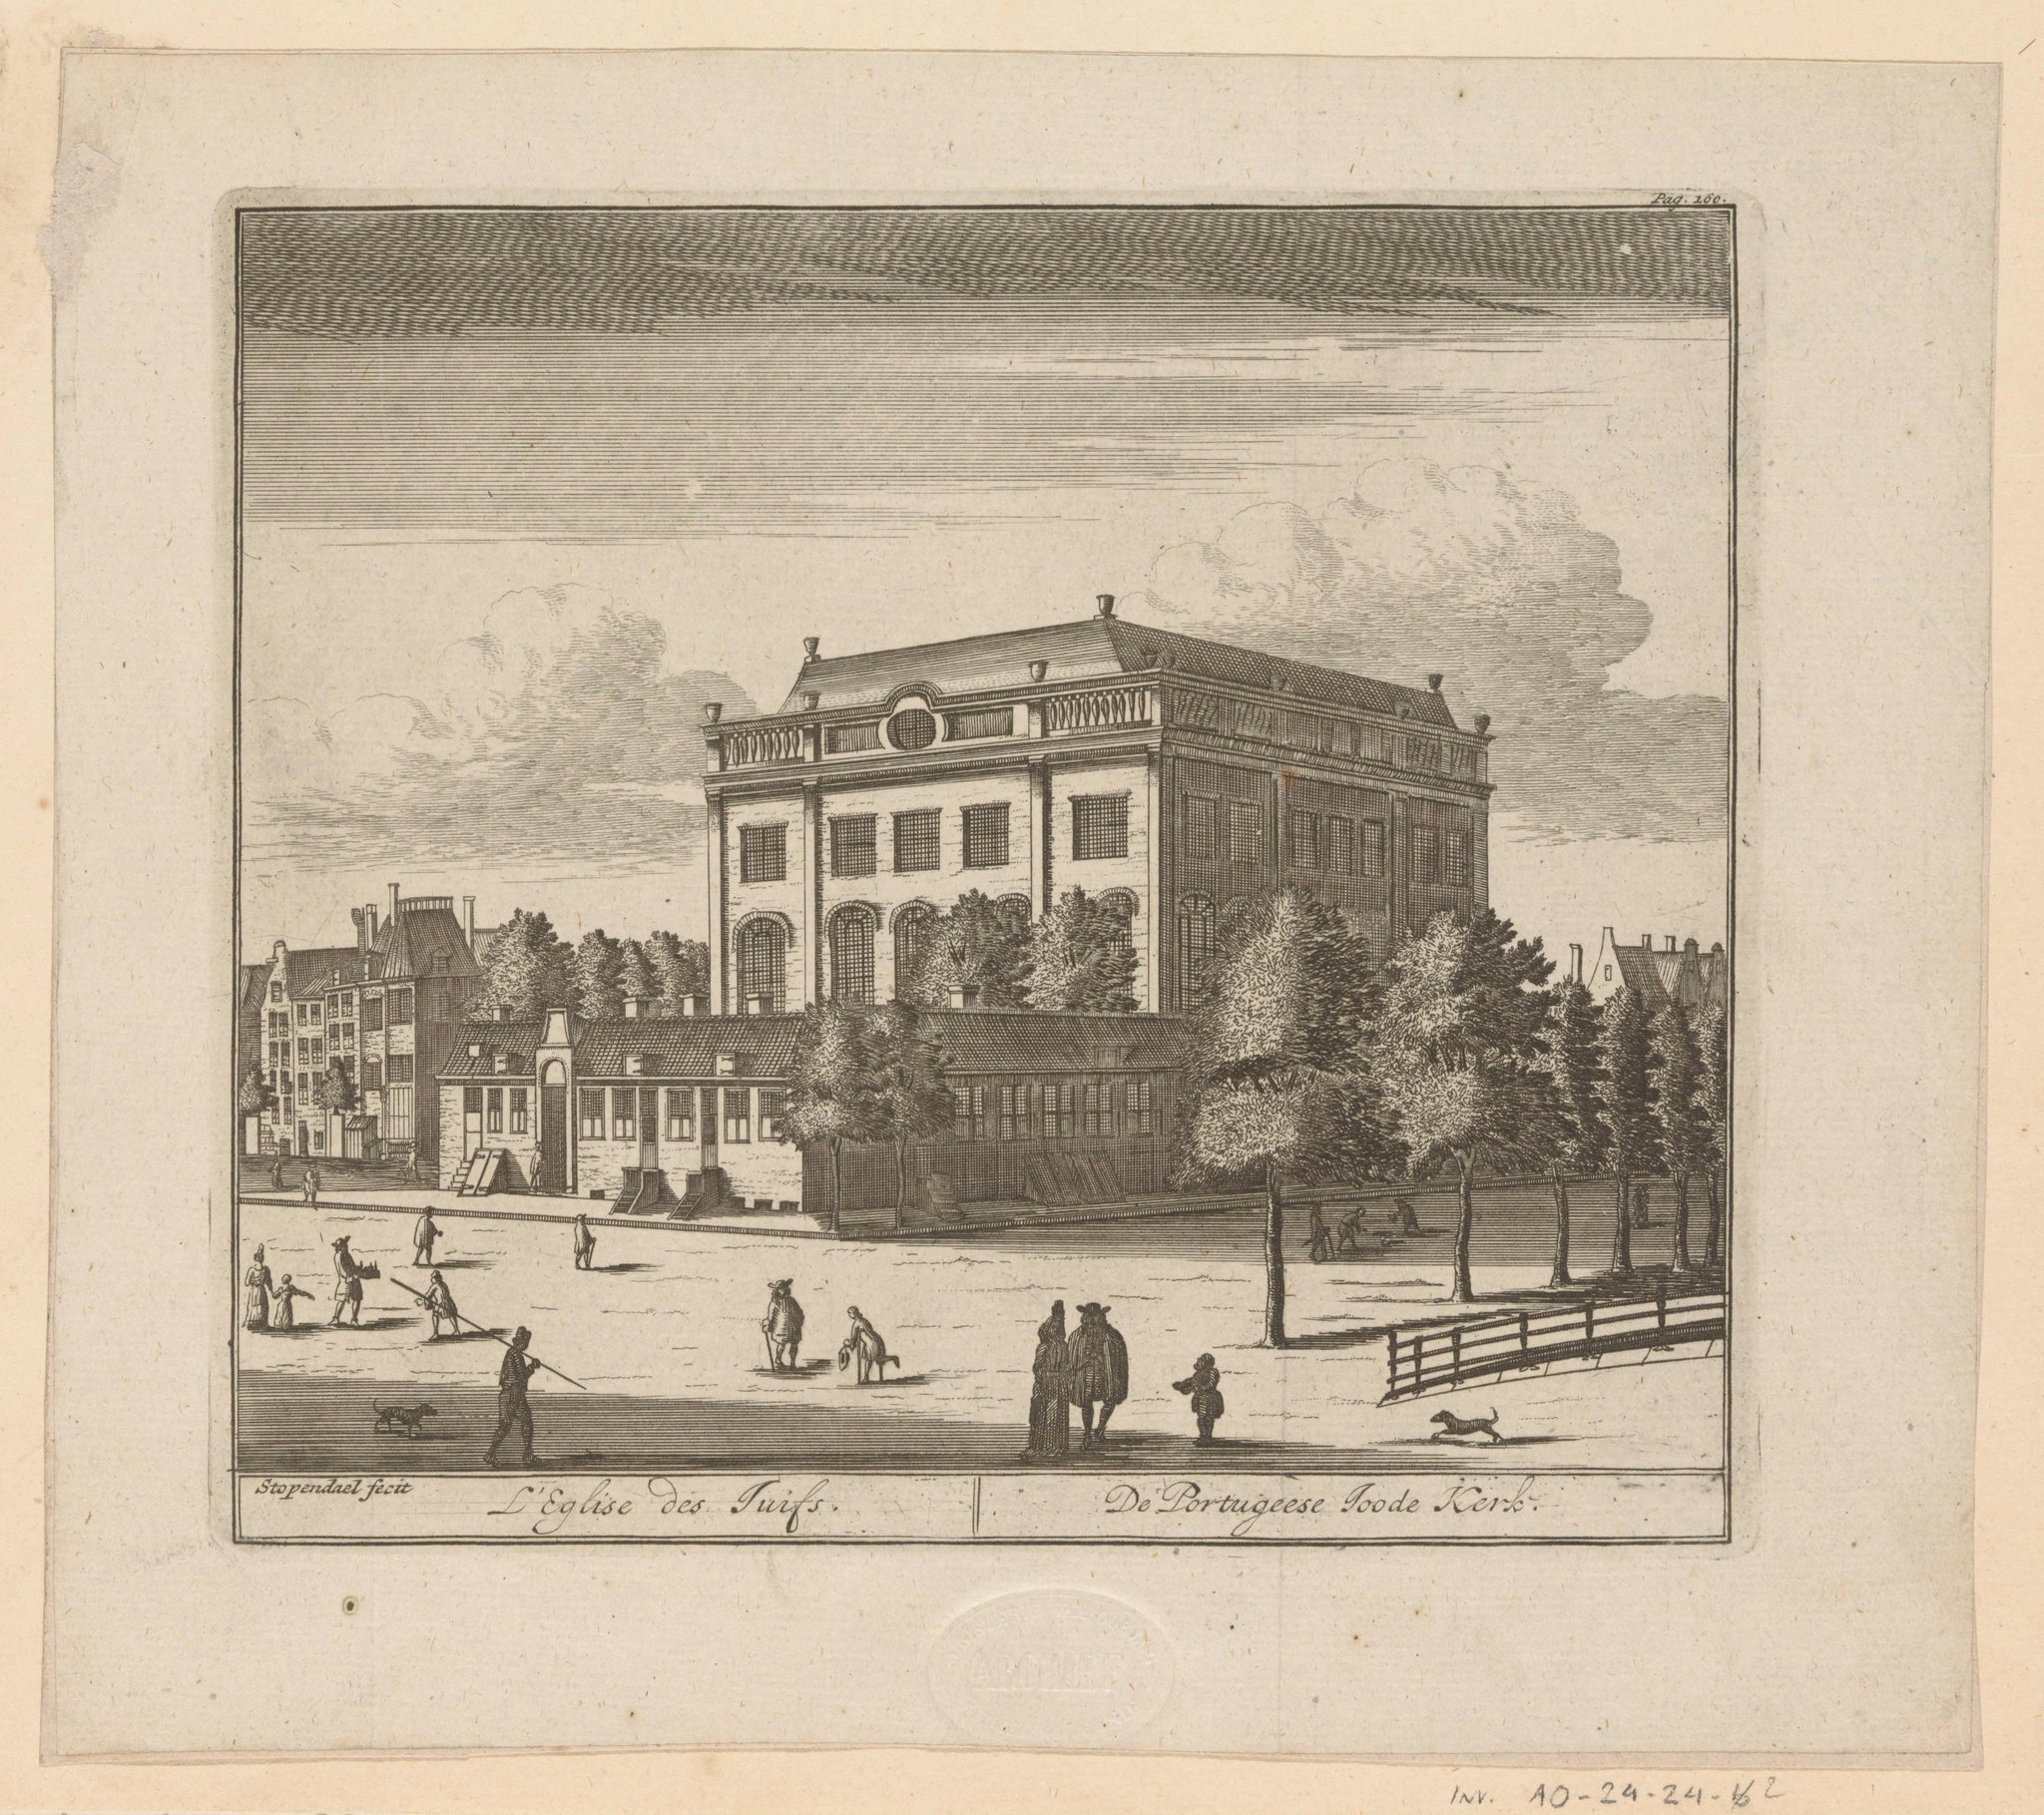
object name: book illustration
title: L'Eglise des Juifs / De Portugeese Joode Kerk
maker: daniël stopendaal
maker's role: print maker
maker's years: 1672-1726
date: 1685-1726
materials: paper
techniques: engraving, etching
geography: amsterdam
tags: 'sephardim' ~ jewish communities, the synagogue (as building and place of worship ~ jewish religion), street (+ city(-scape) with figures, staffage)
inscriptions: check stamp: ‘Archief Ministerie van Oorlog Afdeeling Genie’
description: Gezicht op de Portugese Synagoge te Amsterdam, met links de Rapenburgerstraat en rechts de Deventer Houtmarkt (het huidige Jonas Daniël Meijerplein). Op staat verschillende figuren. Rechtsboven genummerd: Pag. 160. Onder de voorstelling de titel in het Nederlands en Frans.